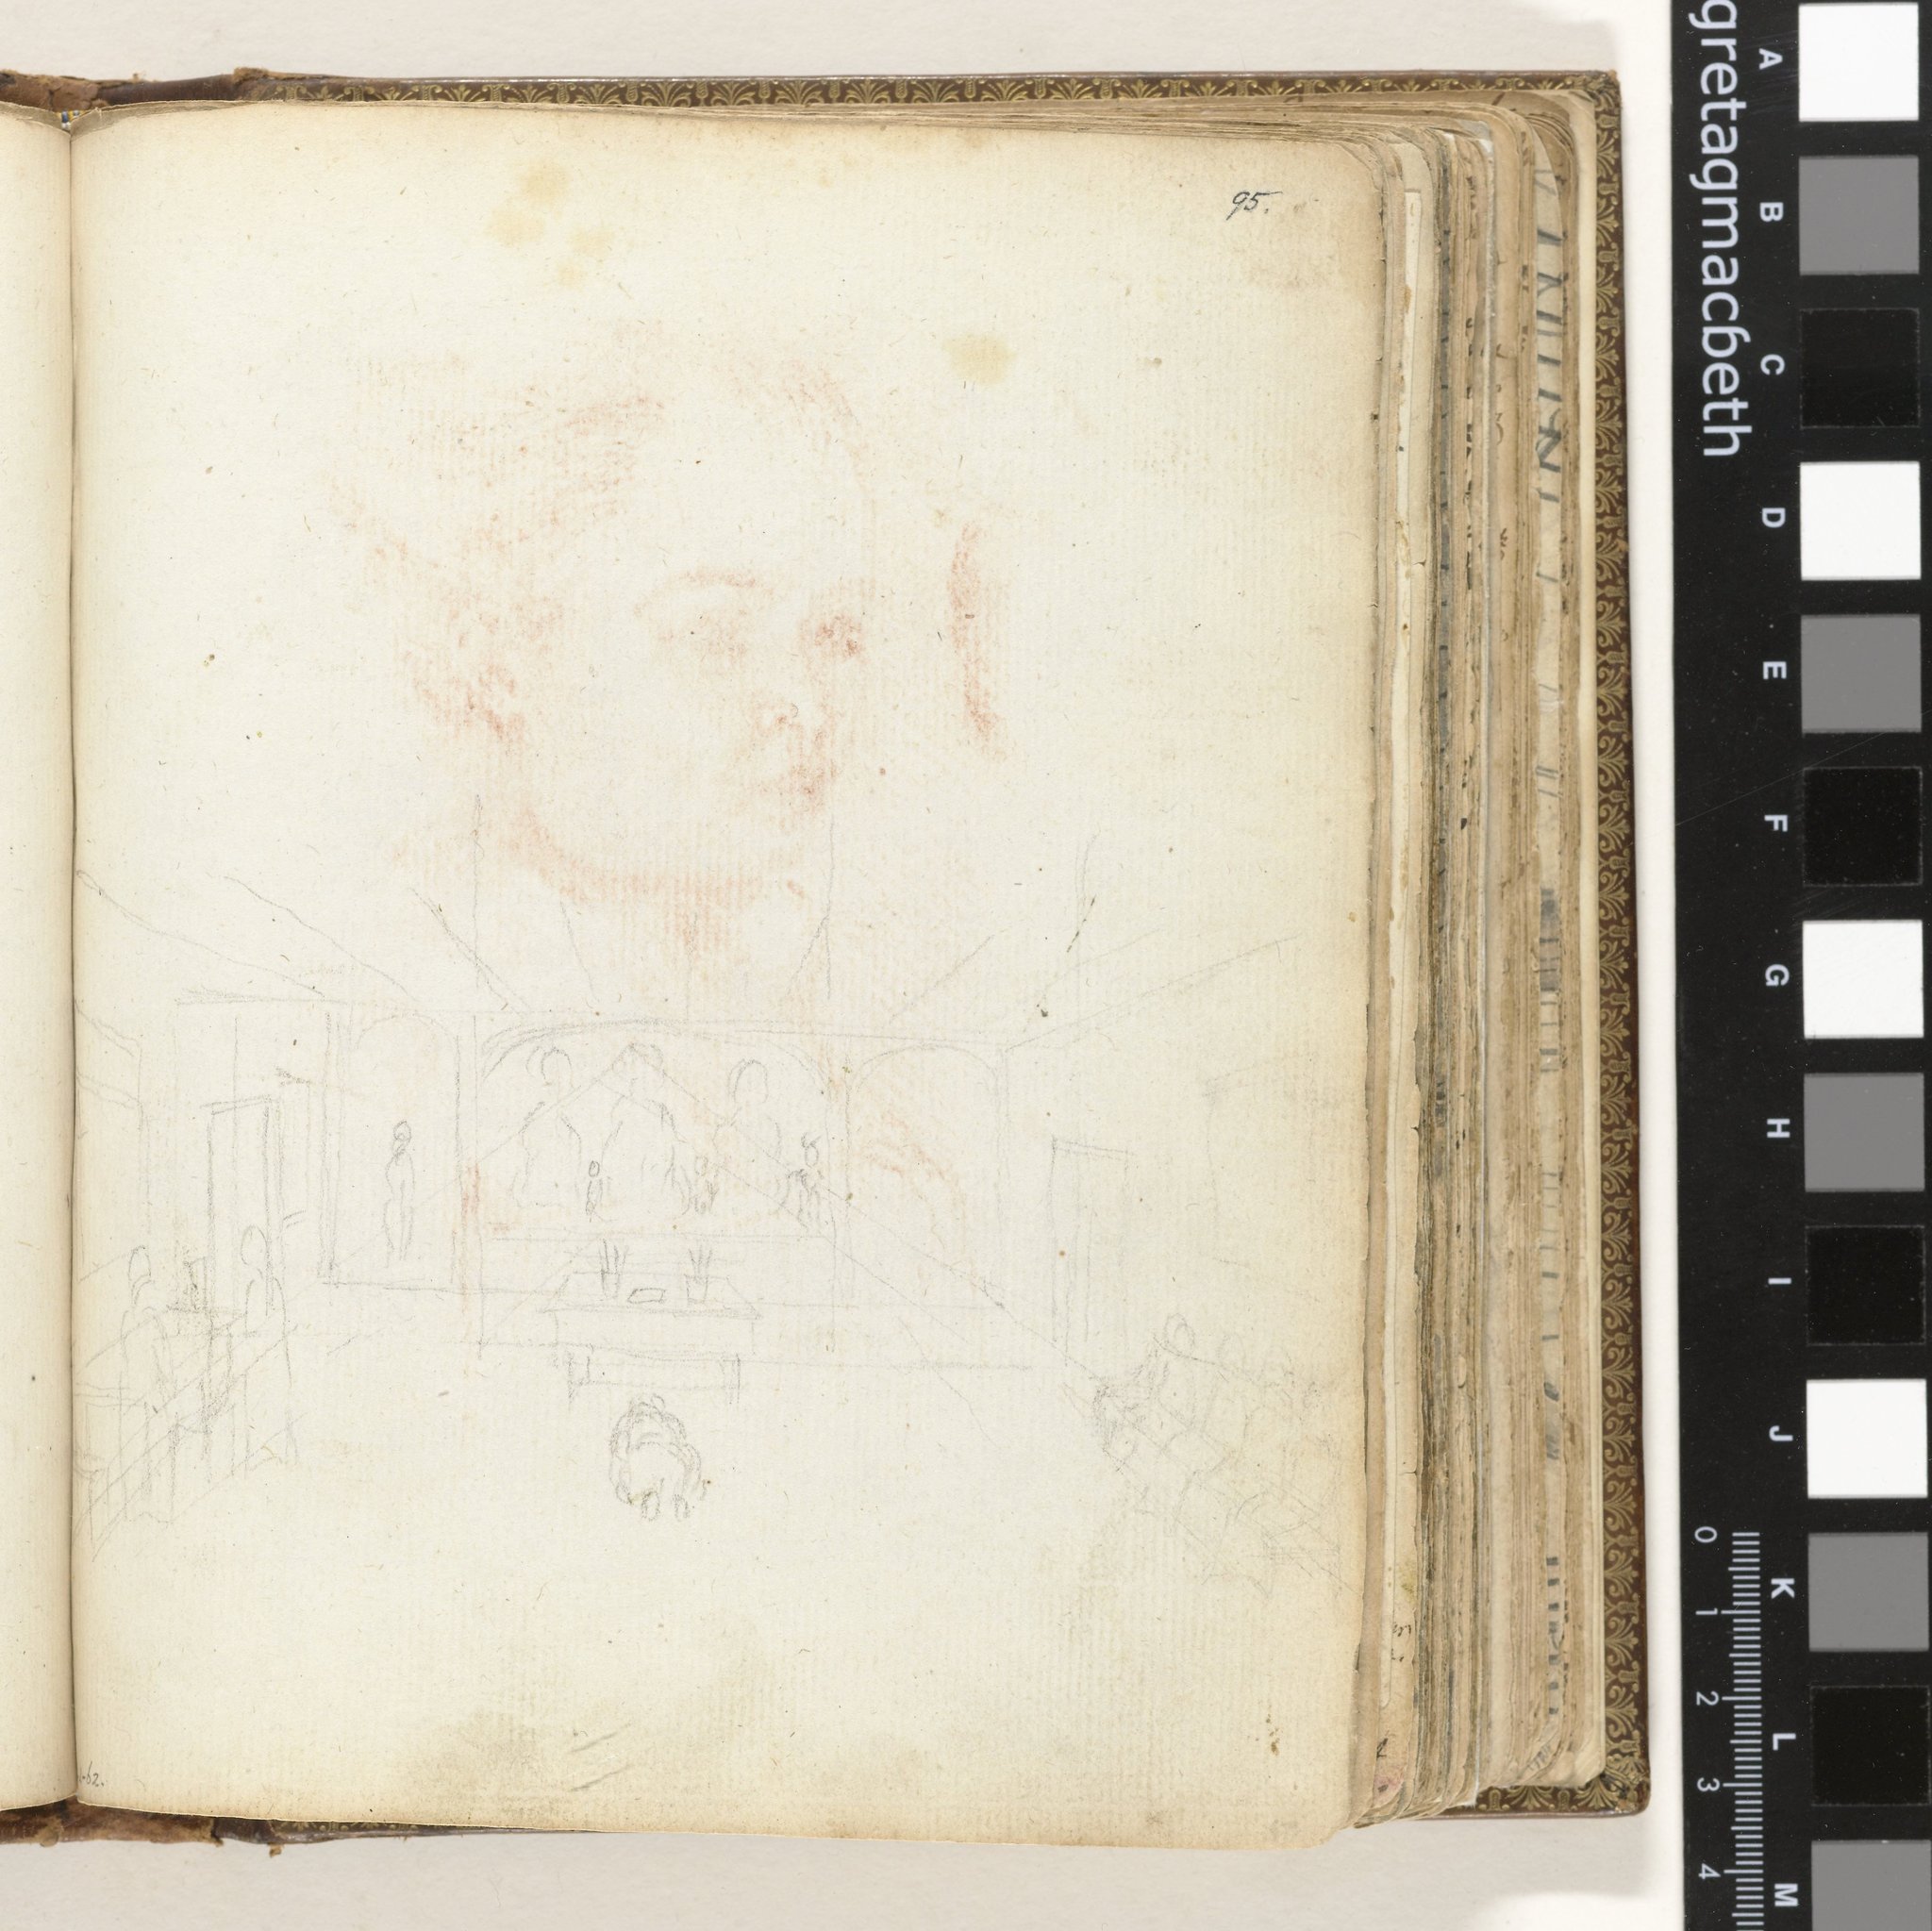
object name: drawing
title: Gezantschap van de VOC op audiëntie bij de vorst van Kandy, Sri Rajadi Raja Sinha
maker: jan brandes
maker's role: draughtsman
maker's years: 1743-1808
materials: paper, pencil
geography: colombo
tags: audition; ruler giving audience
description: Potloodschets van de ontvangst door de koning van Kandy van de Compagniesambassade (zie NG-377). Vage afdruk van portret in deel 2, p. 108. Onderdeel uit het schetsboek van Jan Brandes, dl. 2 (1808), p. 95.